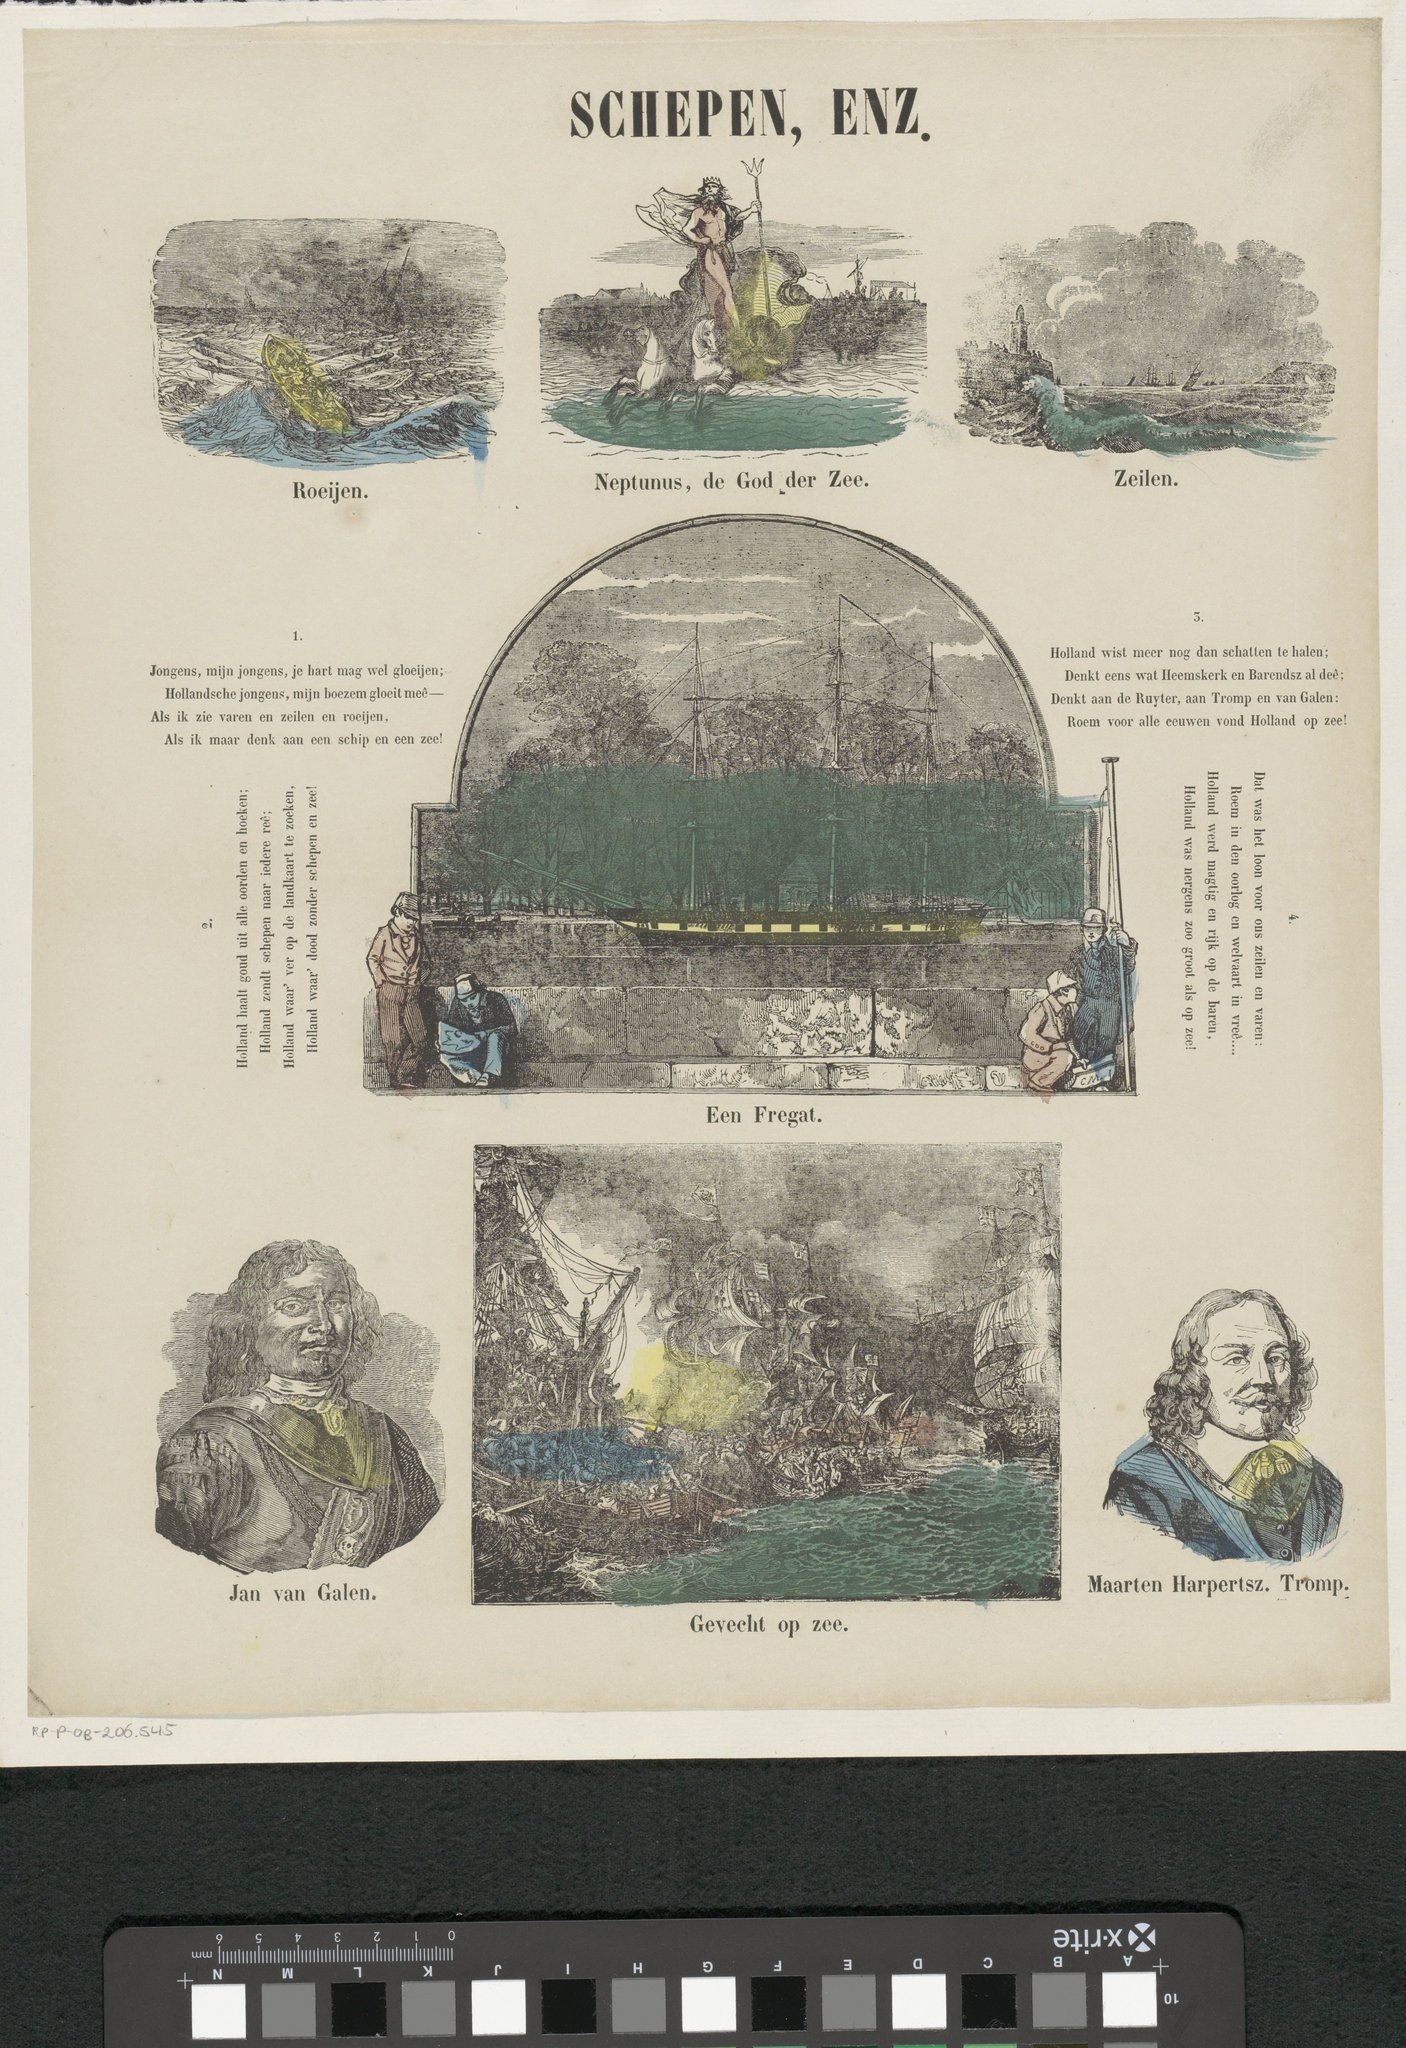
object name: popular print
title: Schepen, enz.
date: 1861-1929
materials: paper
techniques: colour, letterpress printing, engraving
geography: europe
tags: brielle, maarten harpertszoon tromp, gods of the waters: neptune and his environment, ships (in general)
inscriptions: collector's mark: Lugt 2760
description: Blad met 7 voorstellingen van schepen, Neptusus, Jan van Galen en Maarten Harpertszoon Tromp. Onder elke voorstelling een onderschrift. Midden links en rechts vier keer een vierregelig vers in boekdruk.